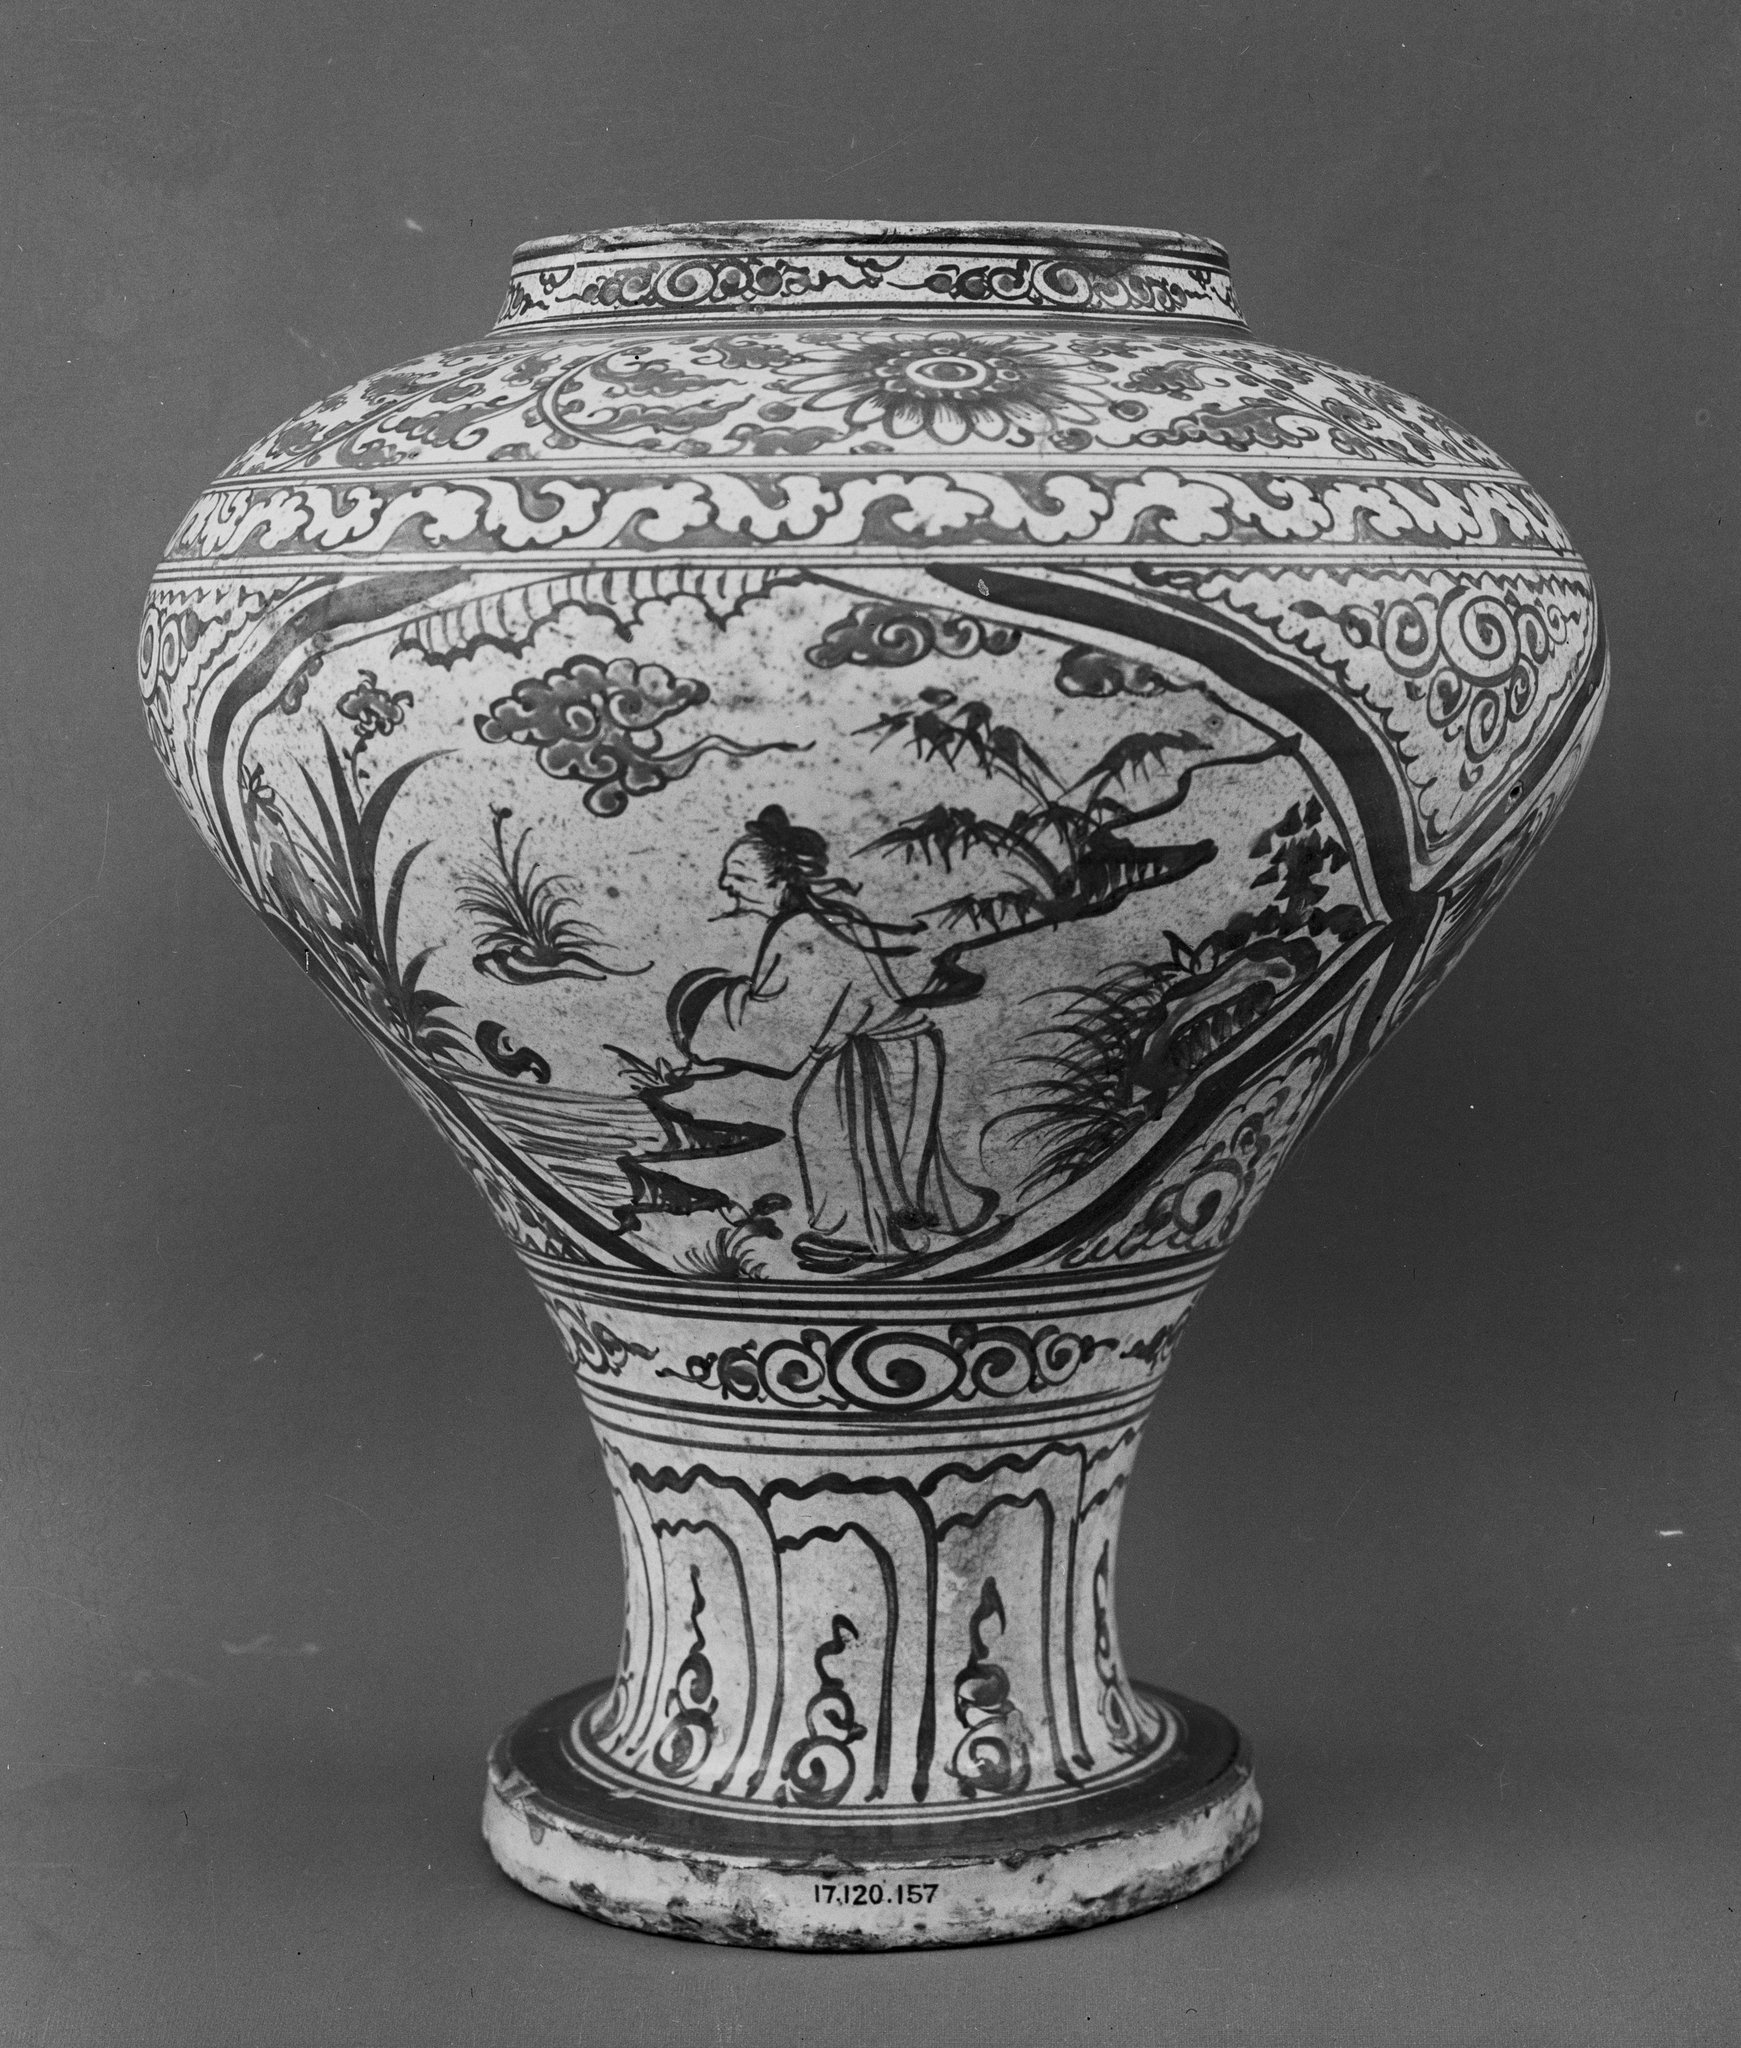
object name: jar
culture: chinese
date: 1368-1644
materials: pottery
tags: human figures